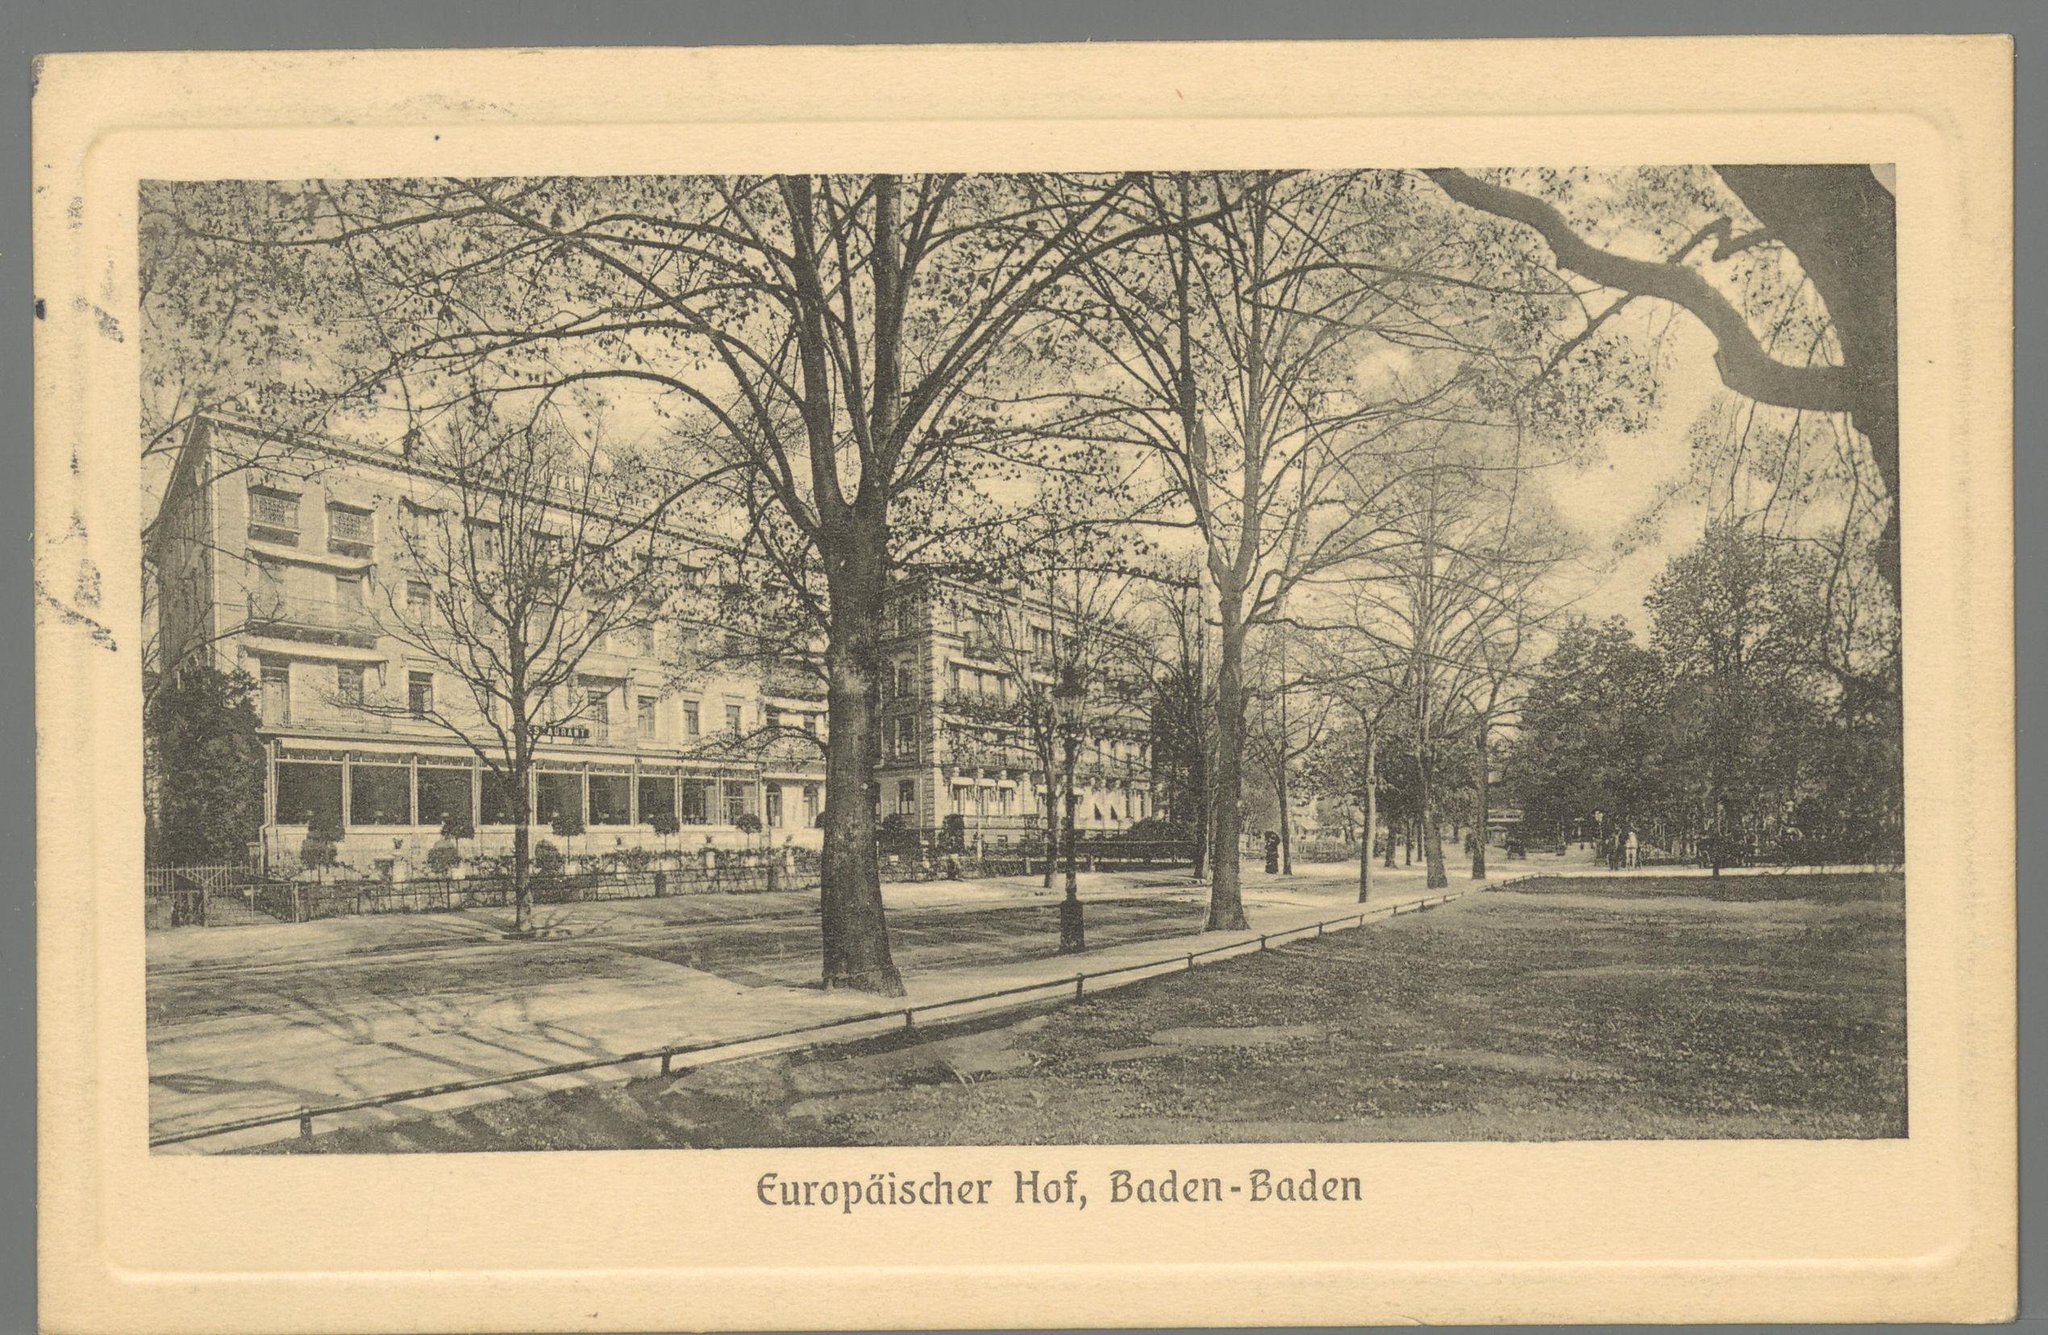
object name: photomechanical print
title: Europäischer Hof, Baden-Baden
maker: Anonymous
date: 1905-1909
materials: cardboard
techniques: photograph, writing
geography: charlottenburg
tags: street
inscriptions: postage stamp